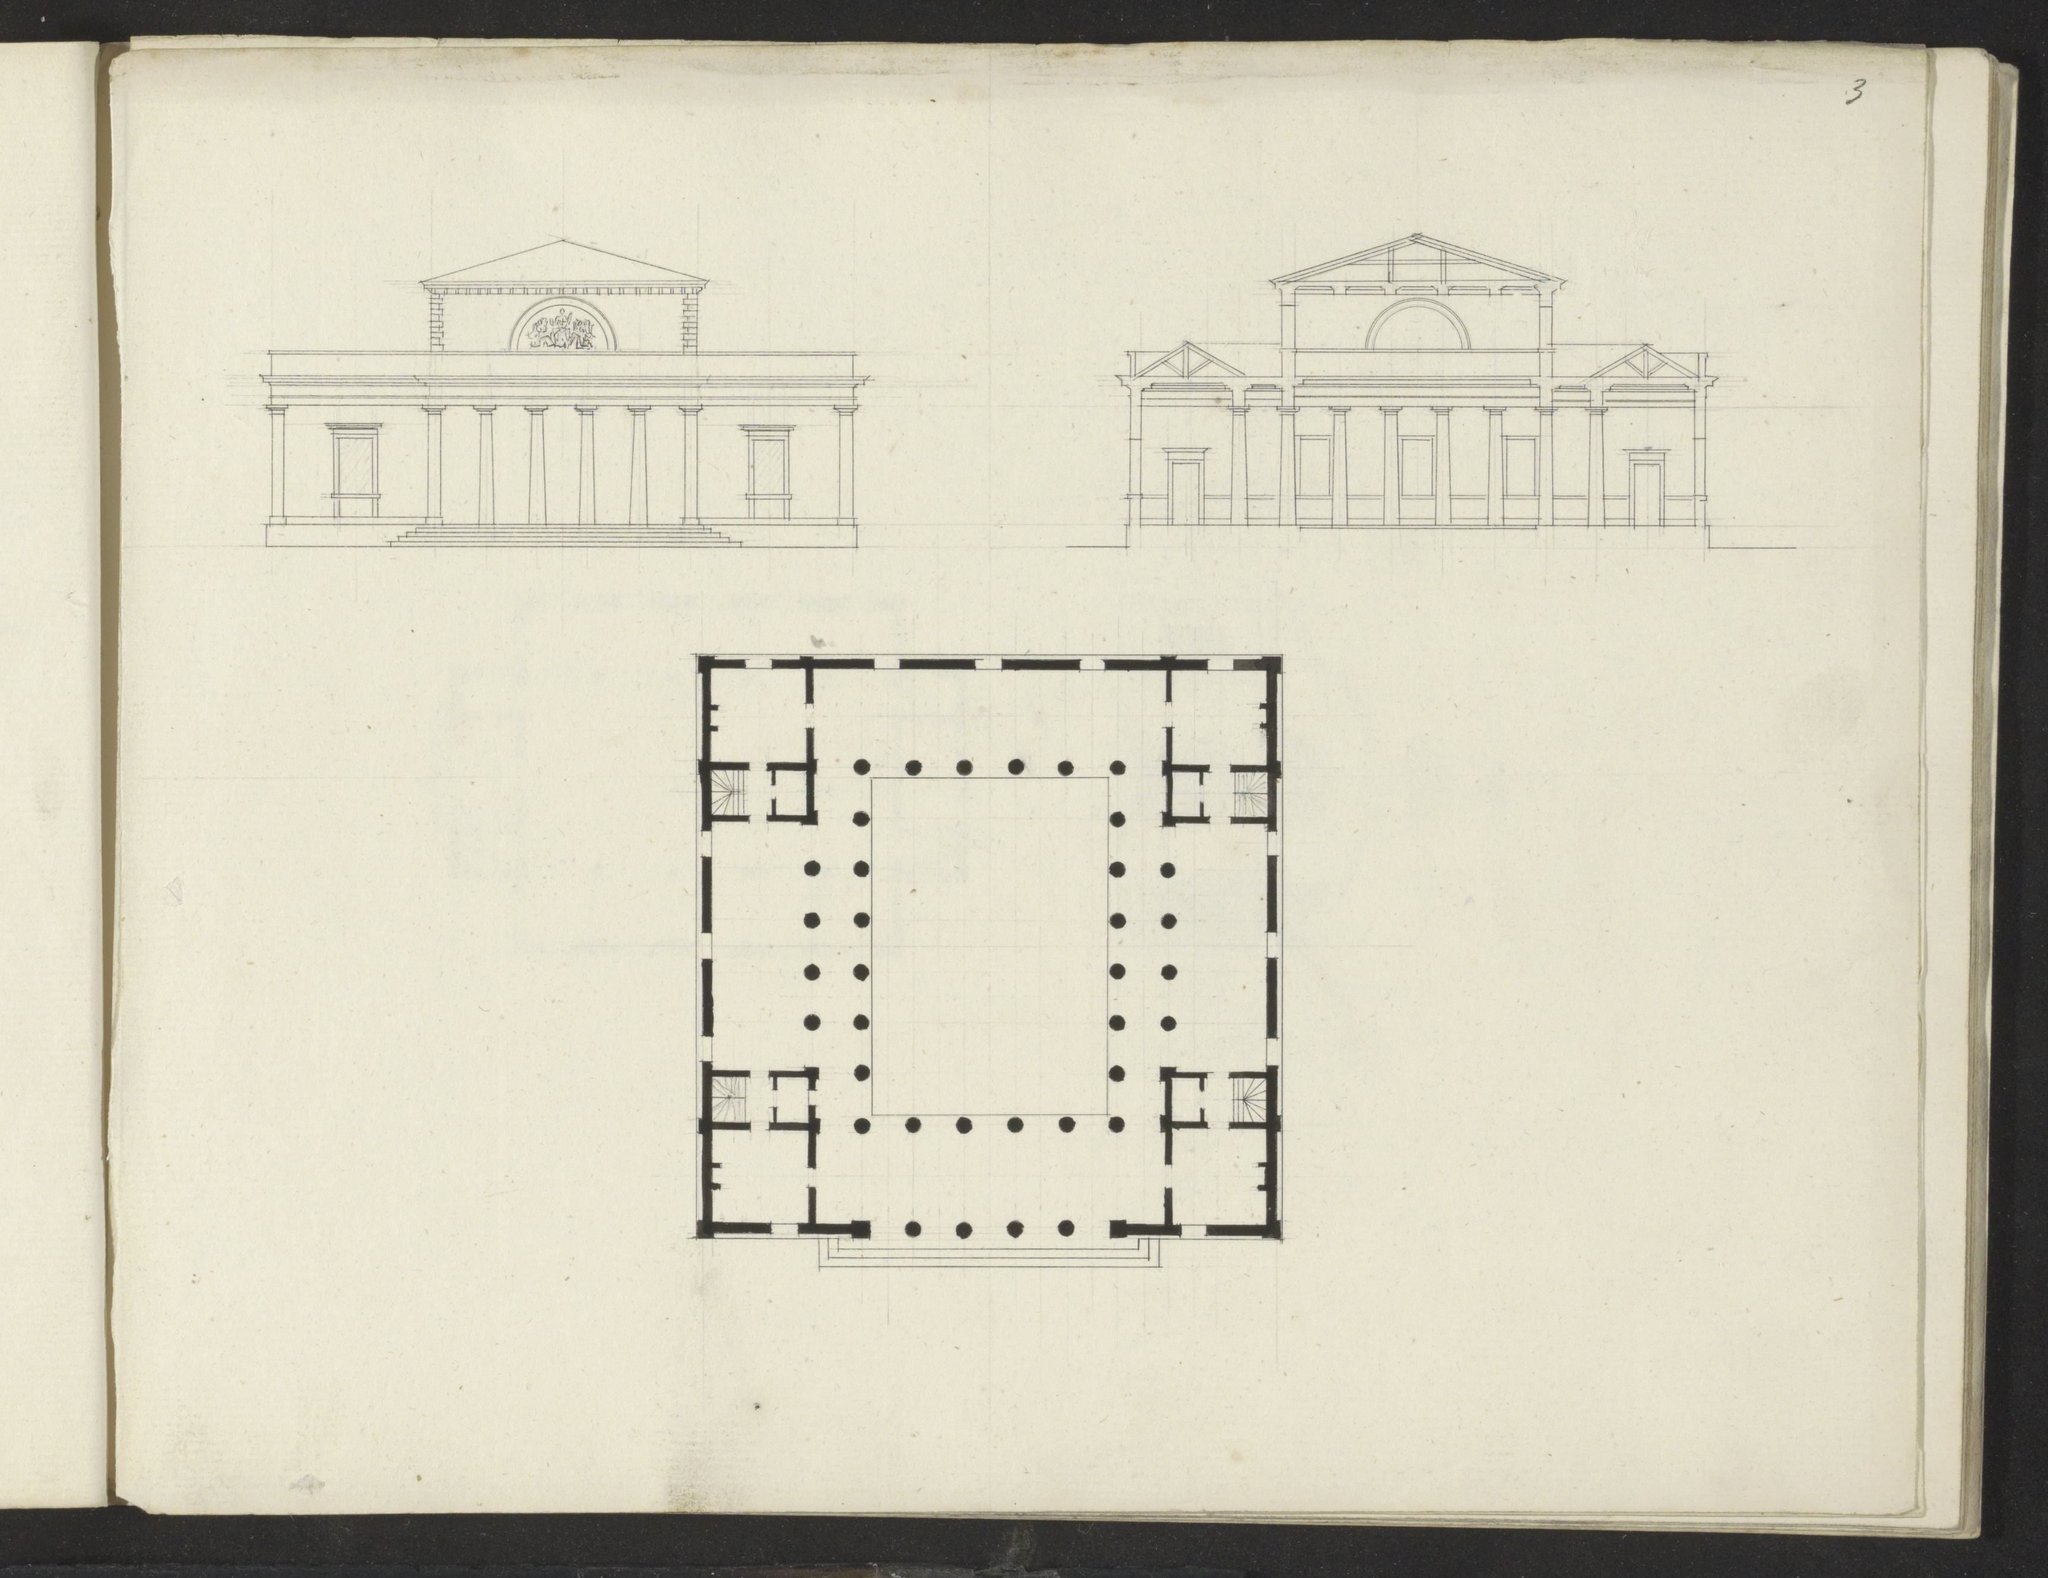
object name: sketchbook leaf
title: Plattegrond en opstanden een villa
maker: willem springer jr.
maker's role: draughtsman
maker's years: 1815-1907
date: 1825-1907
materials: ink, paper, pencil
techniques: pen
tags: façade (of house or building), plan ~ architecture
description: Pagina 3 uit een schetsboek met 28 pagina's.